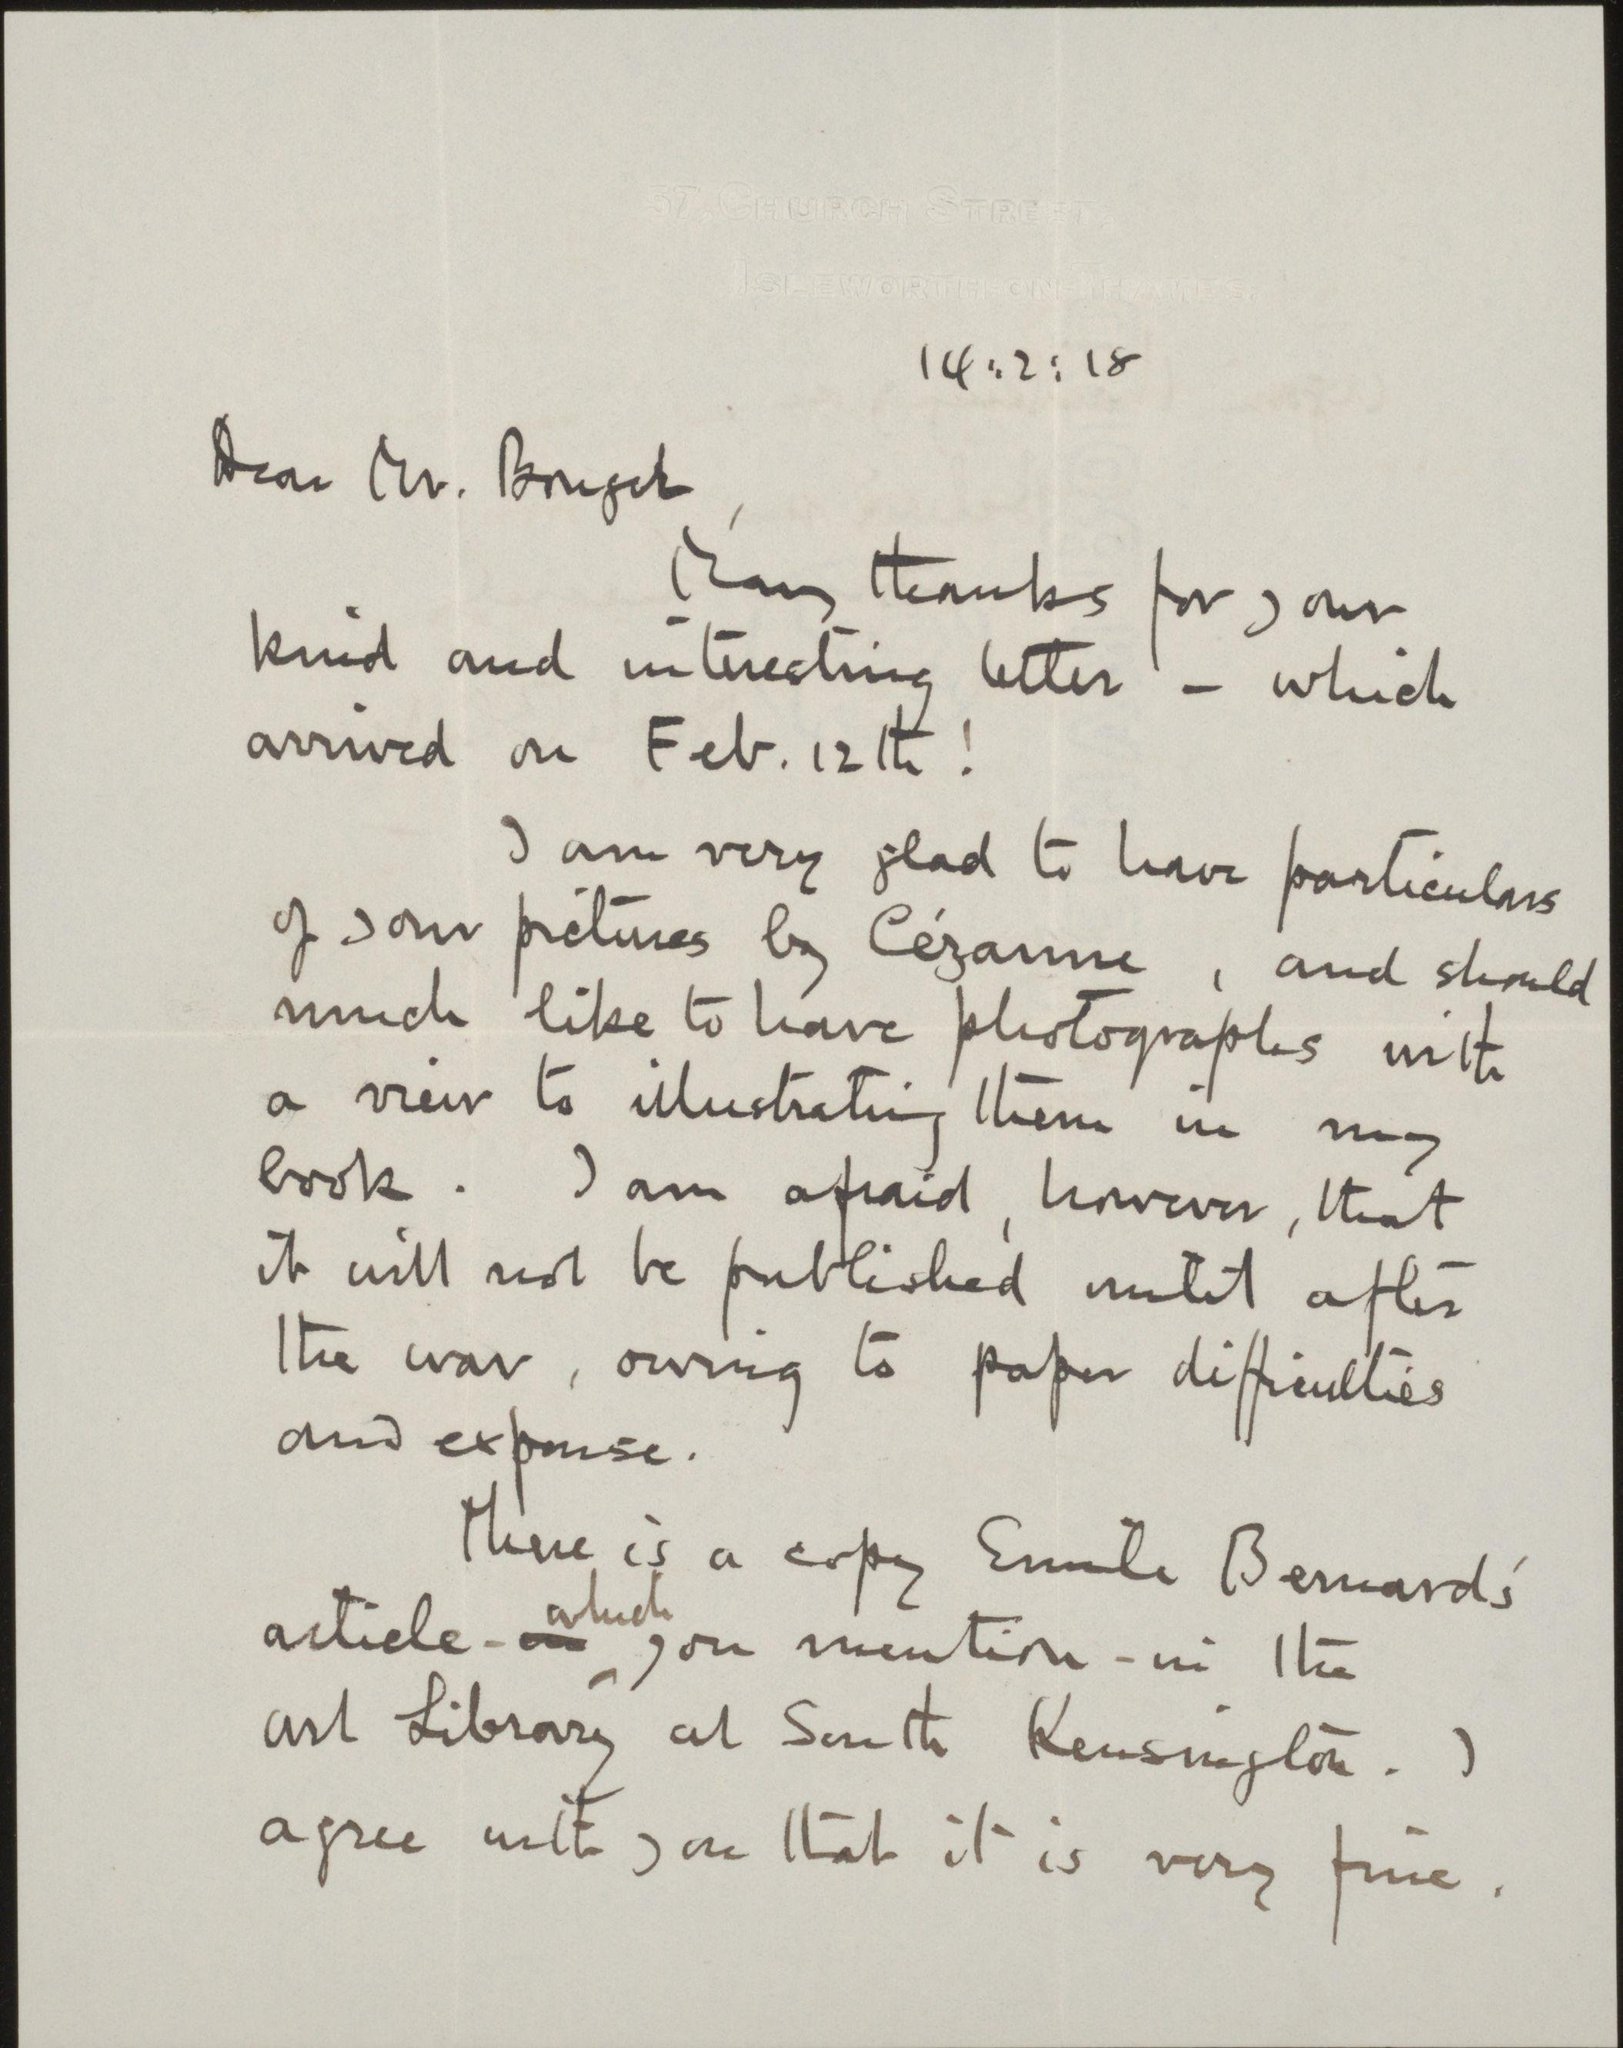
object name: letter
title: Brief aan Andries Bonger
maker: hugh blaker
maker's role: artist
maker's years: 1873-1936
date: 1918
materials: ink, paper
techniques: pen, writing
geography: isleworth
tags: lille, paris, print maker, émile bernard, draughtsman, paul cézanne, andries bonger, photography, cinematography, painting (including book-illumination, miniature-painting), printed matter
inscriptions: watermark